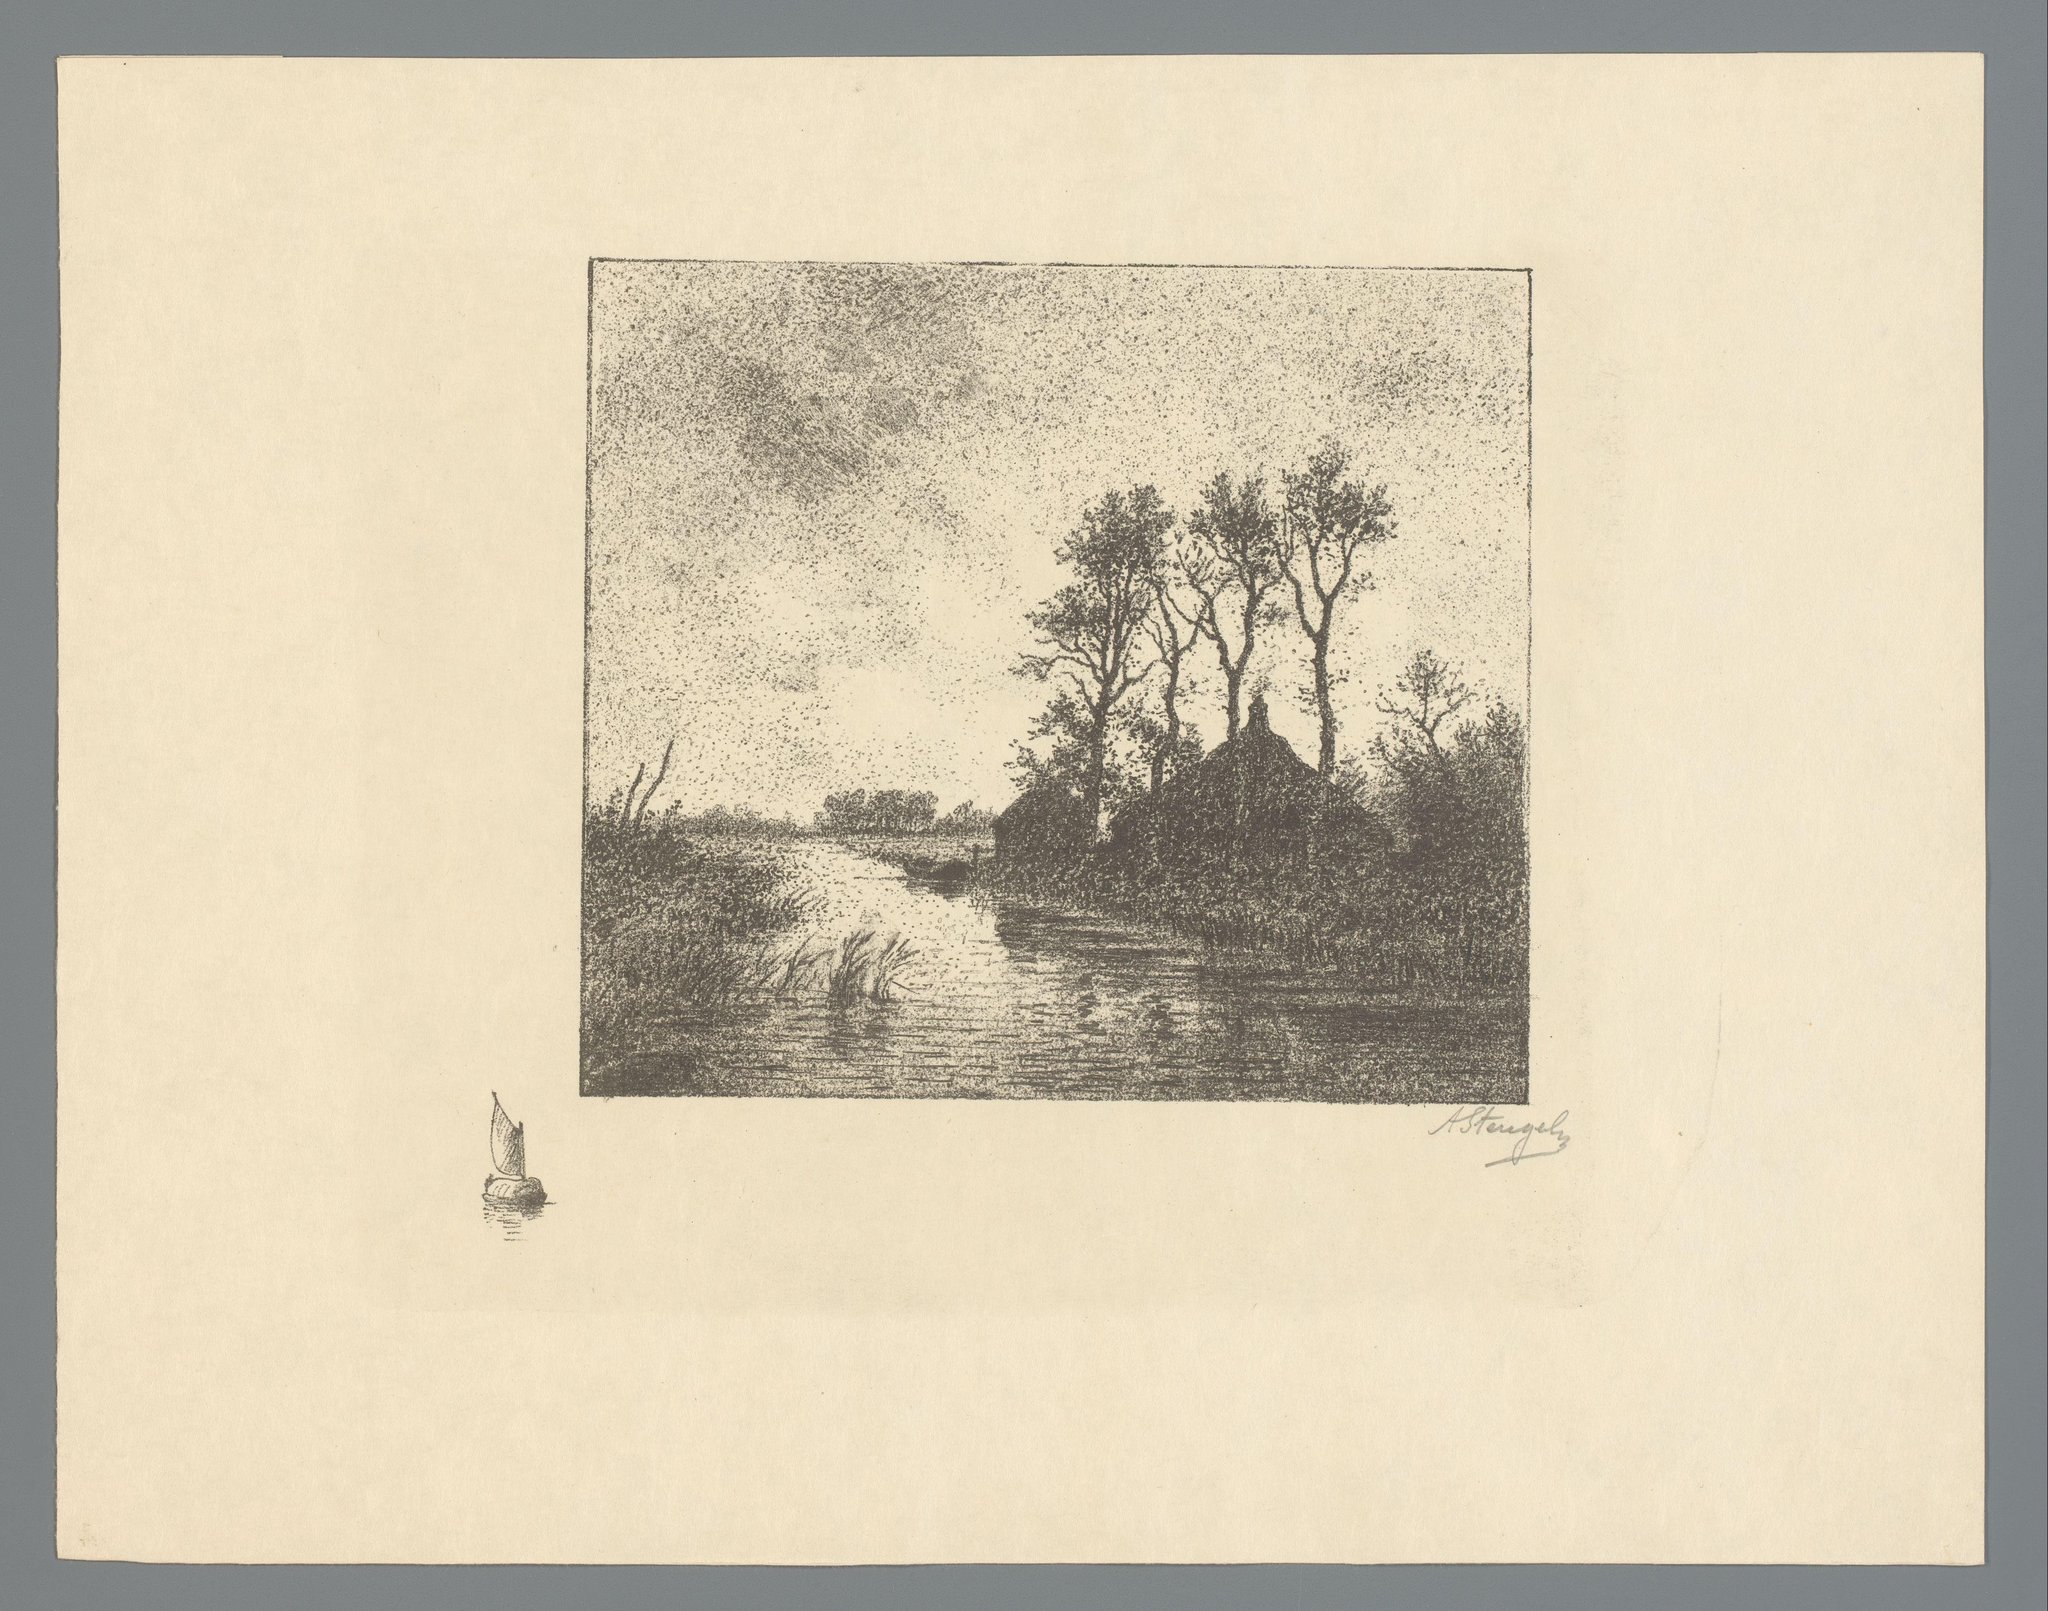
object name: print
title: Vaart bij Hoogeveen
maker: alphonse stengelin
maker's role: painter, print maker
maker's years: 1852-1938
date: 1876-1910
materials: paper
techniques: lithograph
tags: canal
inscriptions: collector's mark: Lugt 2228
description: Linksonder een remarque met een zeilboot.